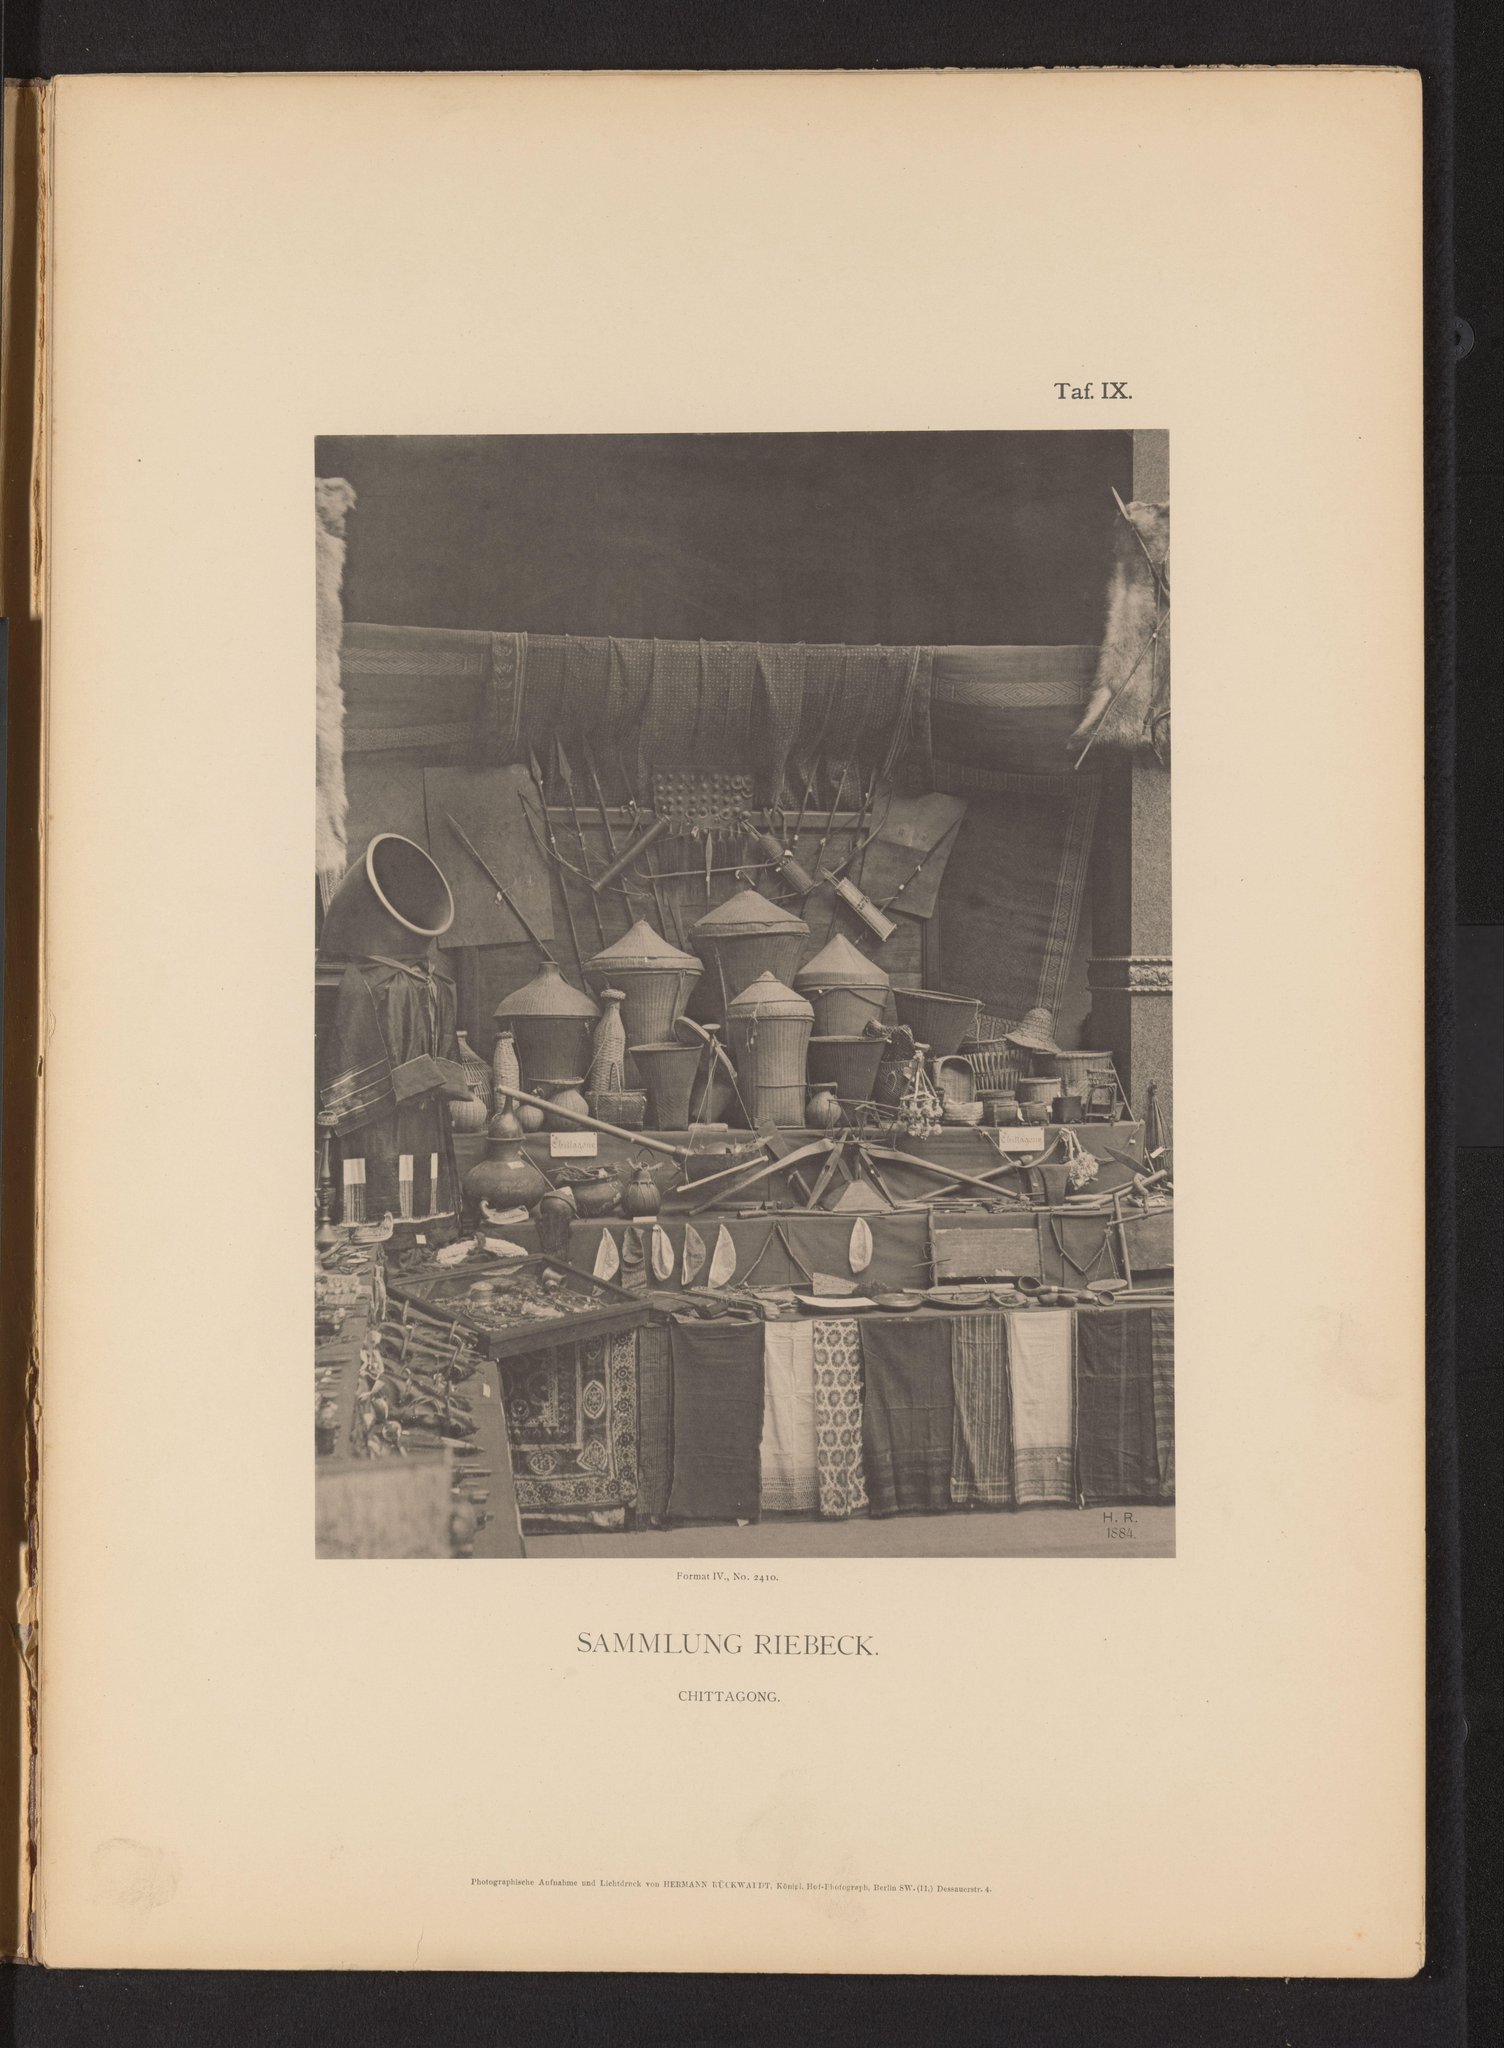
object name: photomechanical print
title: Objecten uit Chittagong uit de verzameling van Emil Riebeck, op de binnenplaats van het Kunstgewerbemuseum in Berlijn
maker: hermann rückwardt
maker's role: fotograaf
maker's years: 1845-1919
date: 1884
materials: paper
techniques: photograph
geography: berlin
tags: container made of plant material other than wood: basket, permanent exhibition, museum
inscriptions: number: ‘Format IV., No. 2410.’, number: ‘Taf. IX.’, address: ‘Photographische Aufnahme und Lichtdruck von HERMANN RÜCKWARDT, Königl. Hof-Photograph, Berlin SW.(11,) Dessauerstr. 4.’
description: Deze prent maakt deel uit van een omslag met 21 prenten en 1 tekstblad.